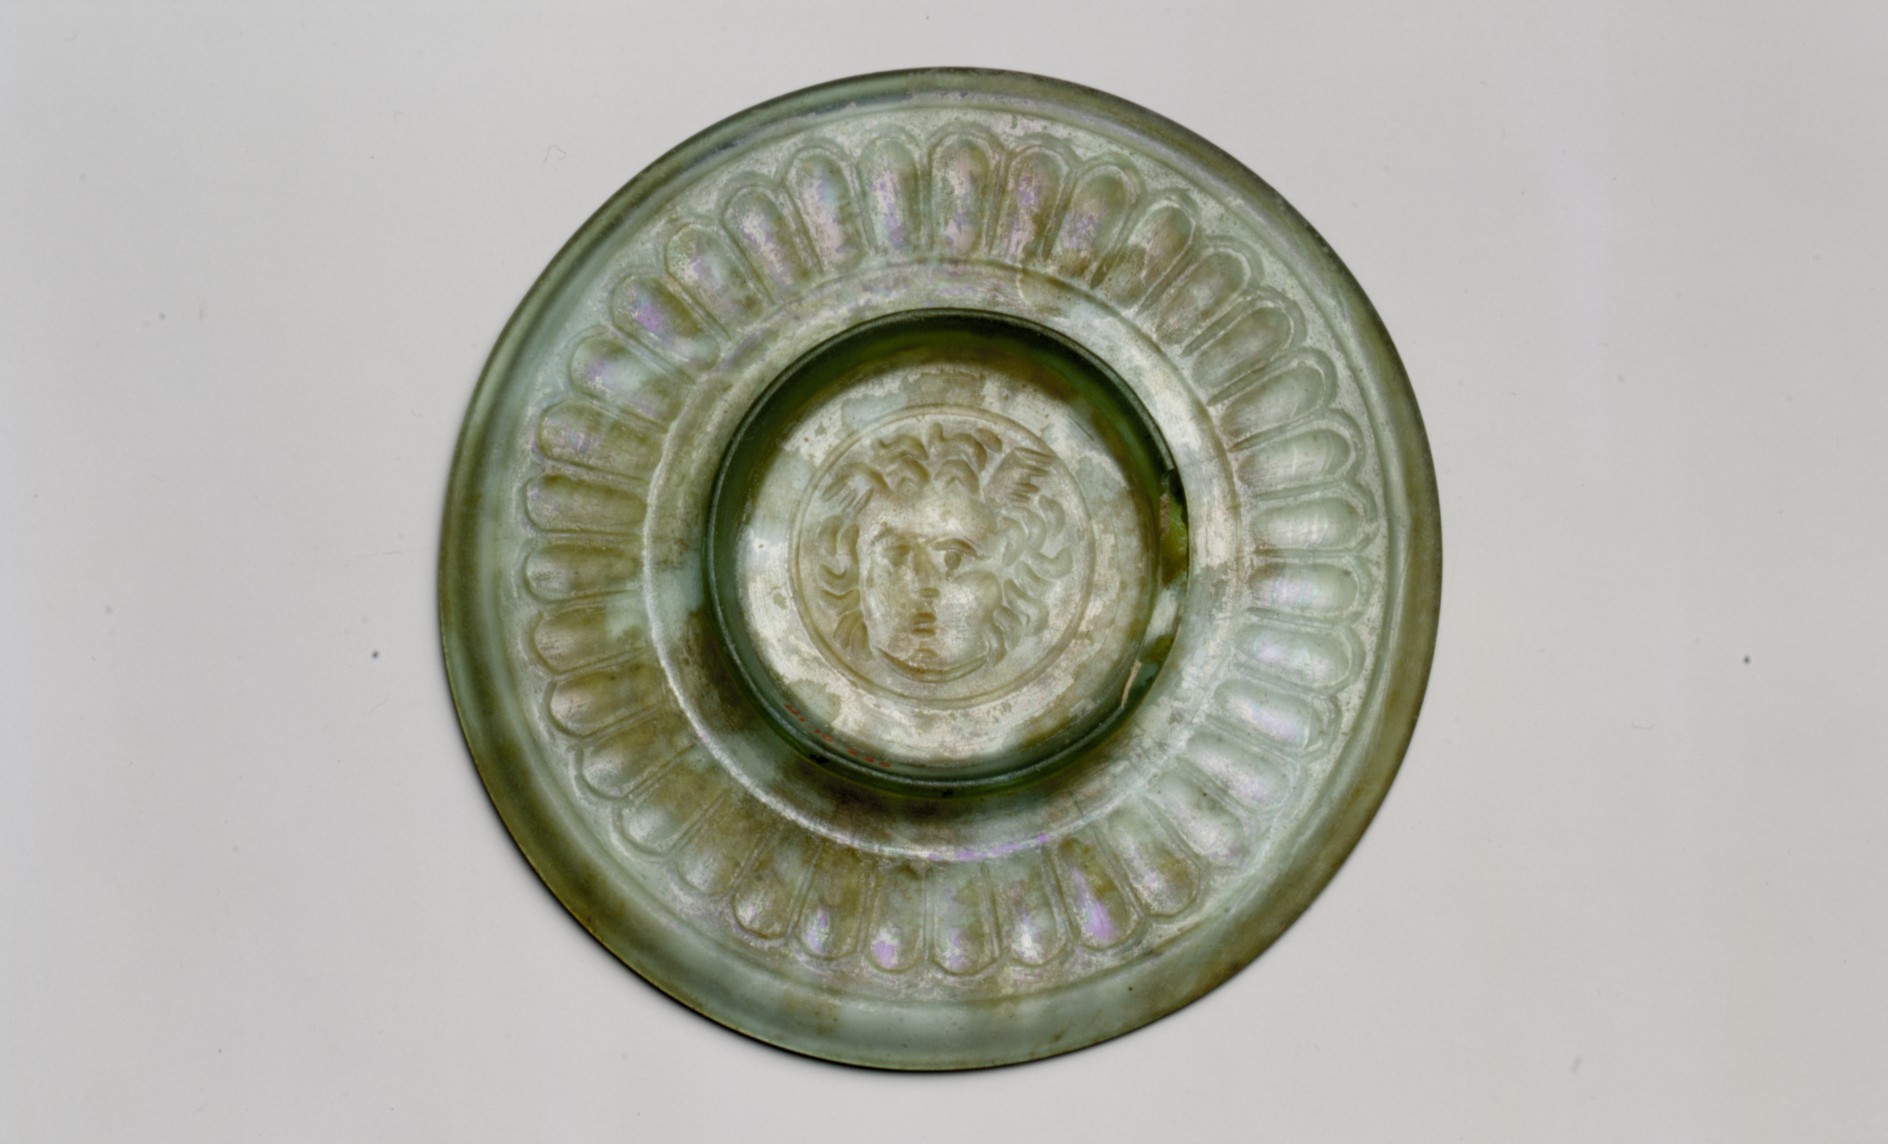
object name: plate with head of medusa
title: Glass plate with head of Medusa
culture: roman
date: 201-300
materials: glass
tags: heads,medusa